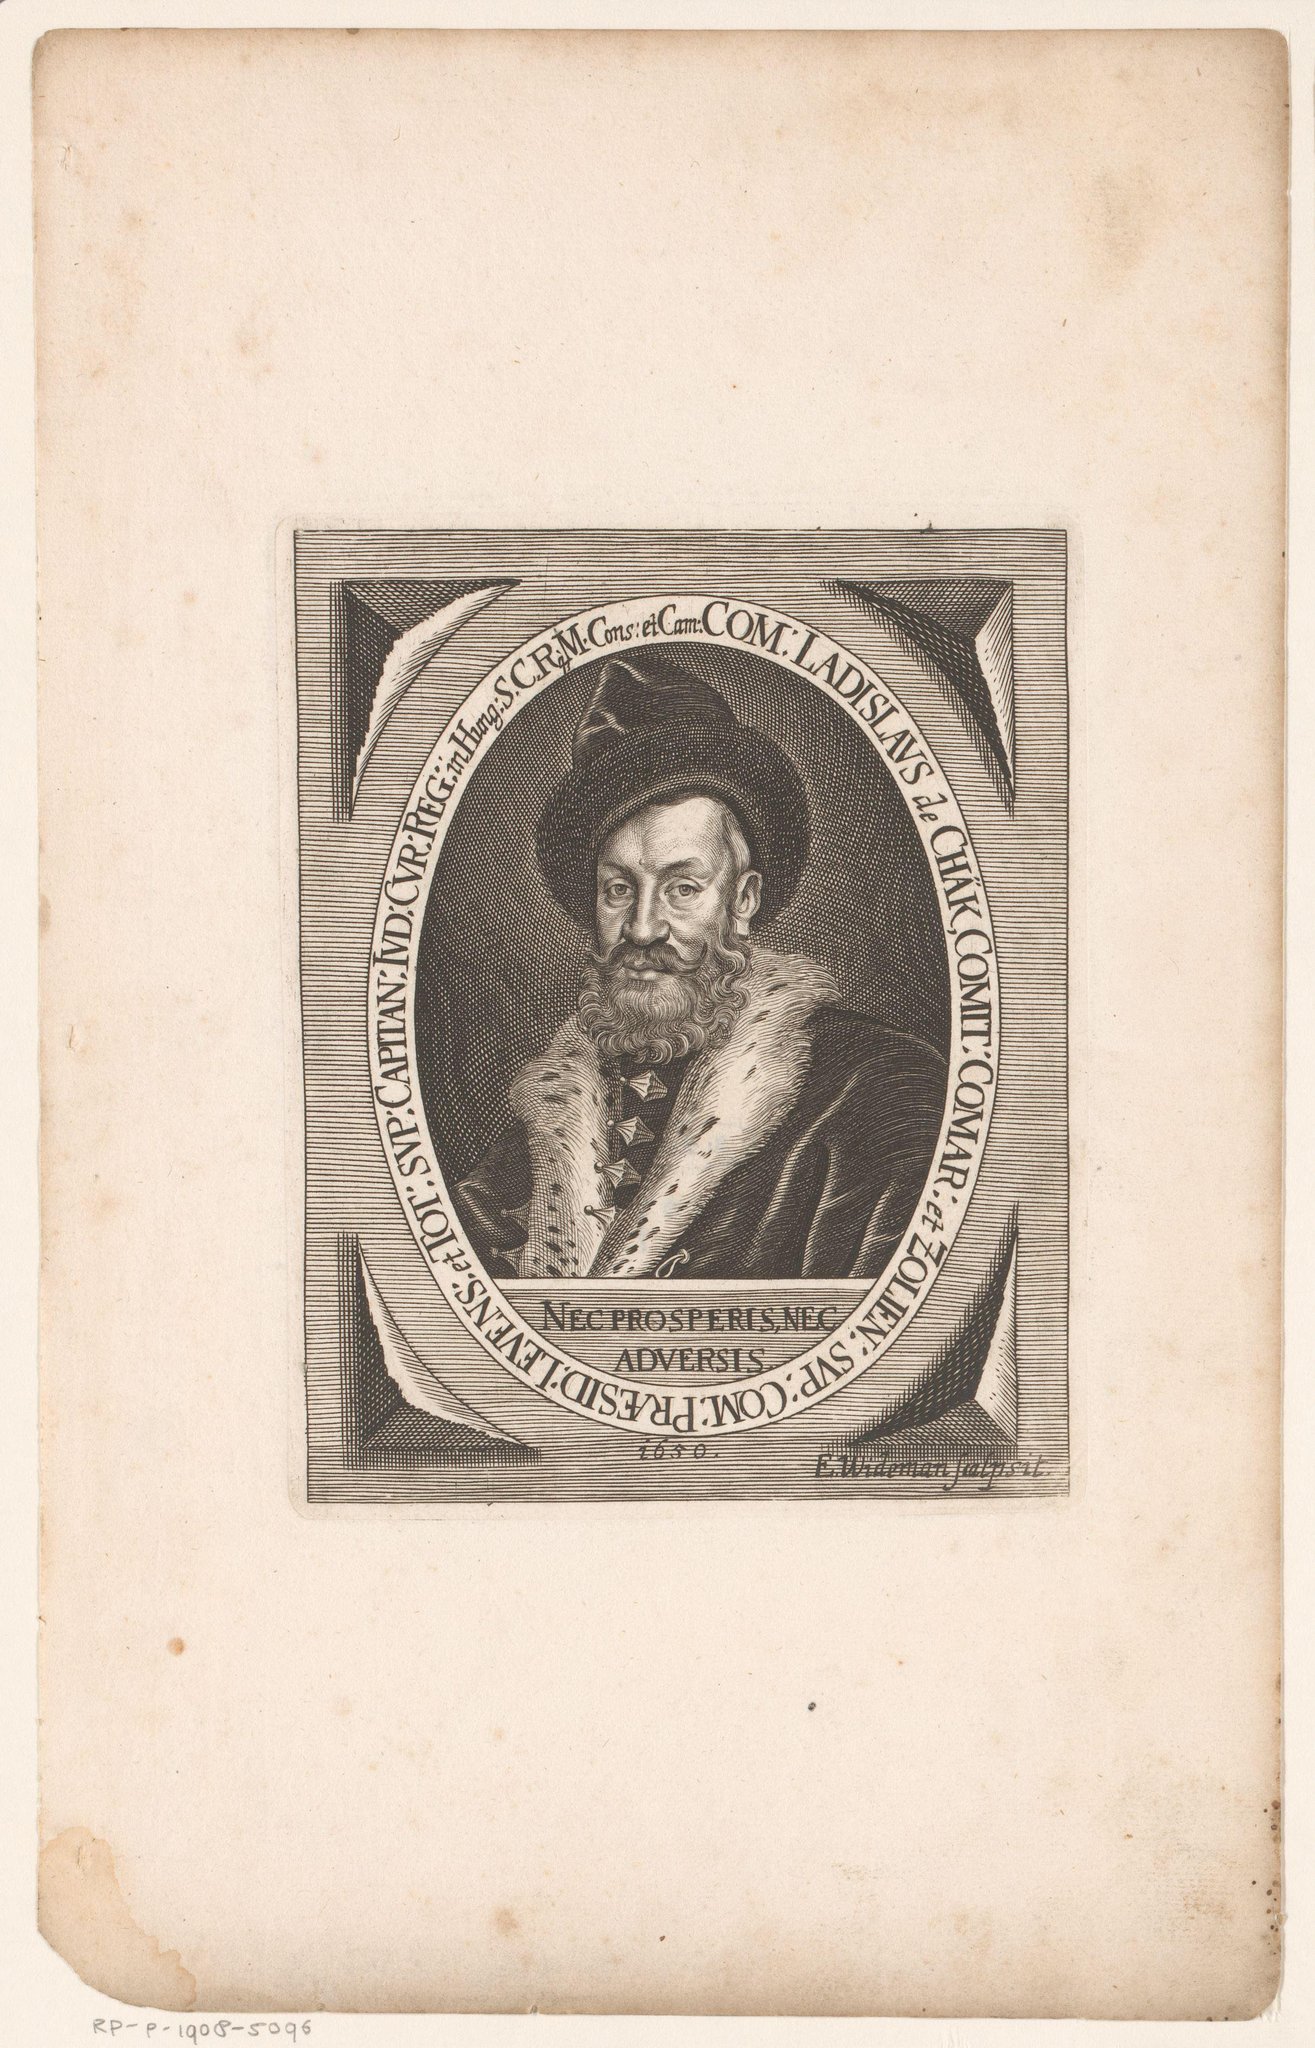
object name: print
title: Portret van Ladislaus de Chäk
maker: elias widemann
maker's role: print maker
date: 1650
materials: paper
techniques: engraving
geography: vienna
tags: historical persons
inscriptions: collector's mark: Lugt 2228